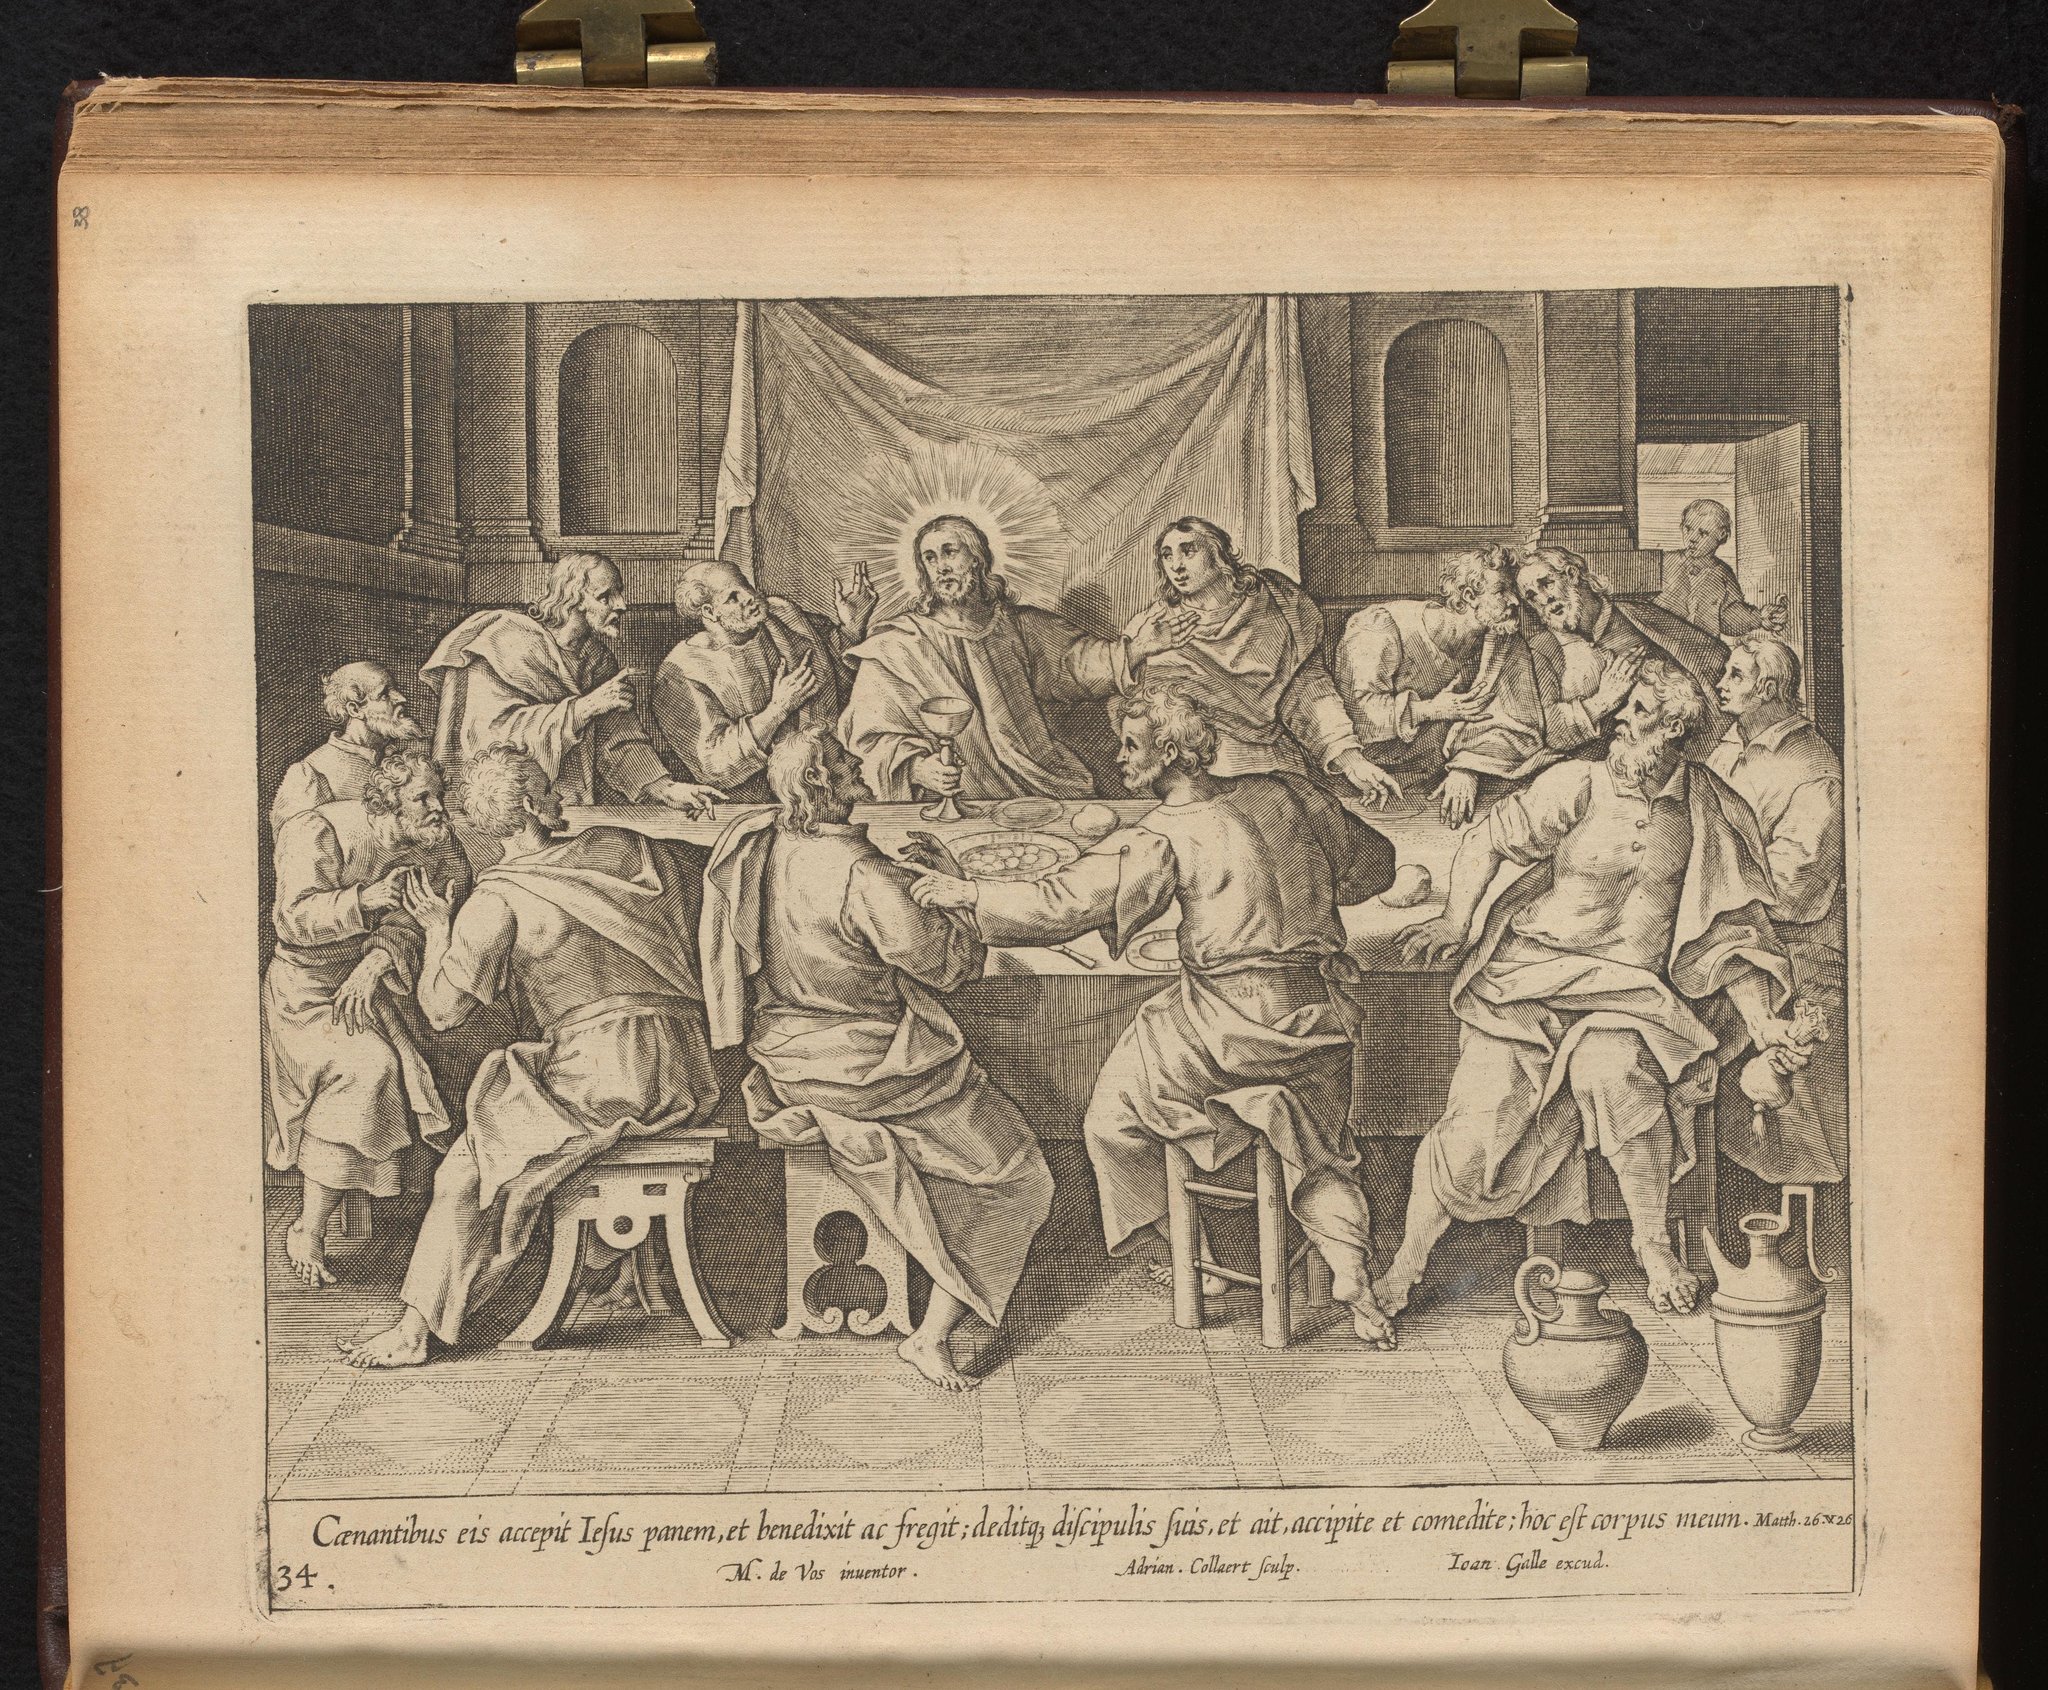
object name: print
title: Vita, passio et Resvrrectio Iesv Christi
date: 1598-1618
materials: paper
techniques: engraving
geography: antwerp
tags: last supper (in general) (matthew 26:21-35; mark 14:18-31; luke 22:3, 22:15-23; john 13:21-38)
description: Prent maakt deel uit van een prentbijbel.